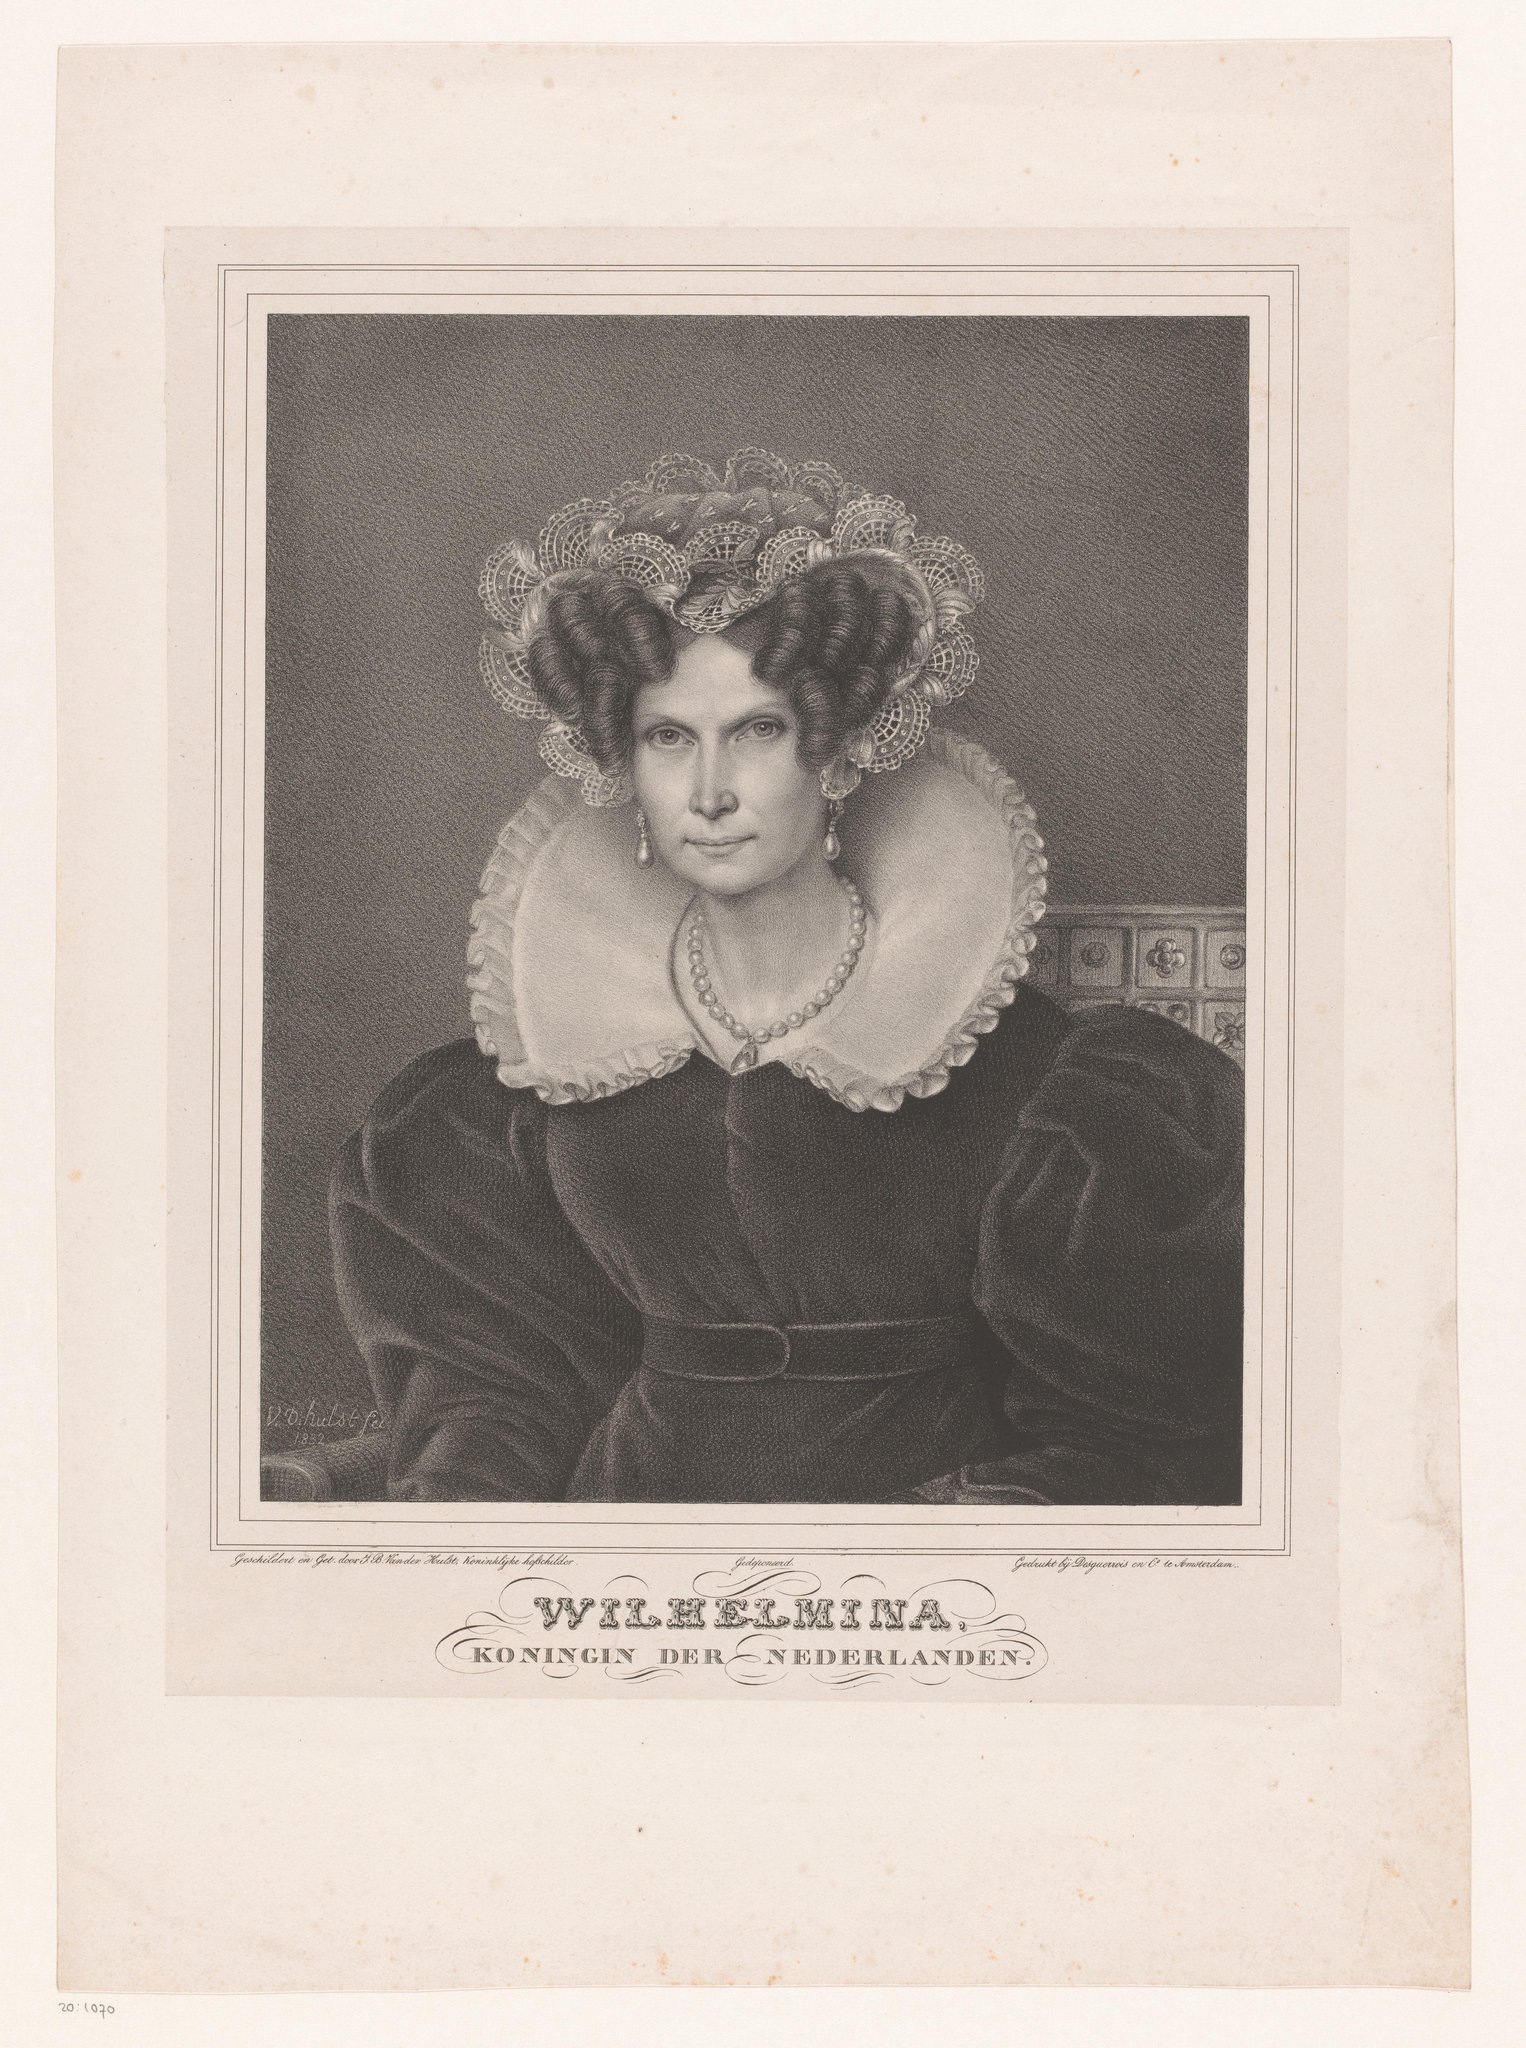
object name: print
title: Portret van Wilhelmina van Pruisen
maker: jean-baptiste van der hulst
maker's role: draughtsman, painter, print maker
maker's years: 1790-1862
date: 1832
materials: paper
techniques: lithograph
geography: amsterdam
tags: berlin, the hague, wilhelmina frederica louisa (koningin der nederlanden), adult woman, historical persons, ear-rings, neck-gear: collar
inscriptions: collector's mark: Lugt 2228